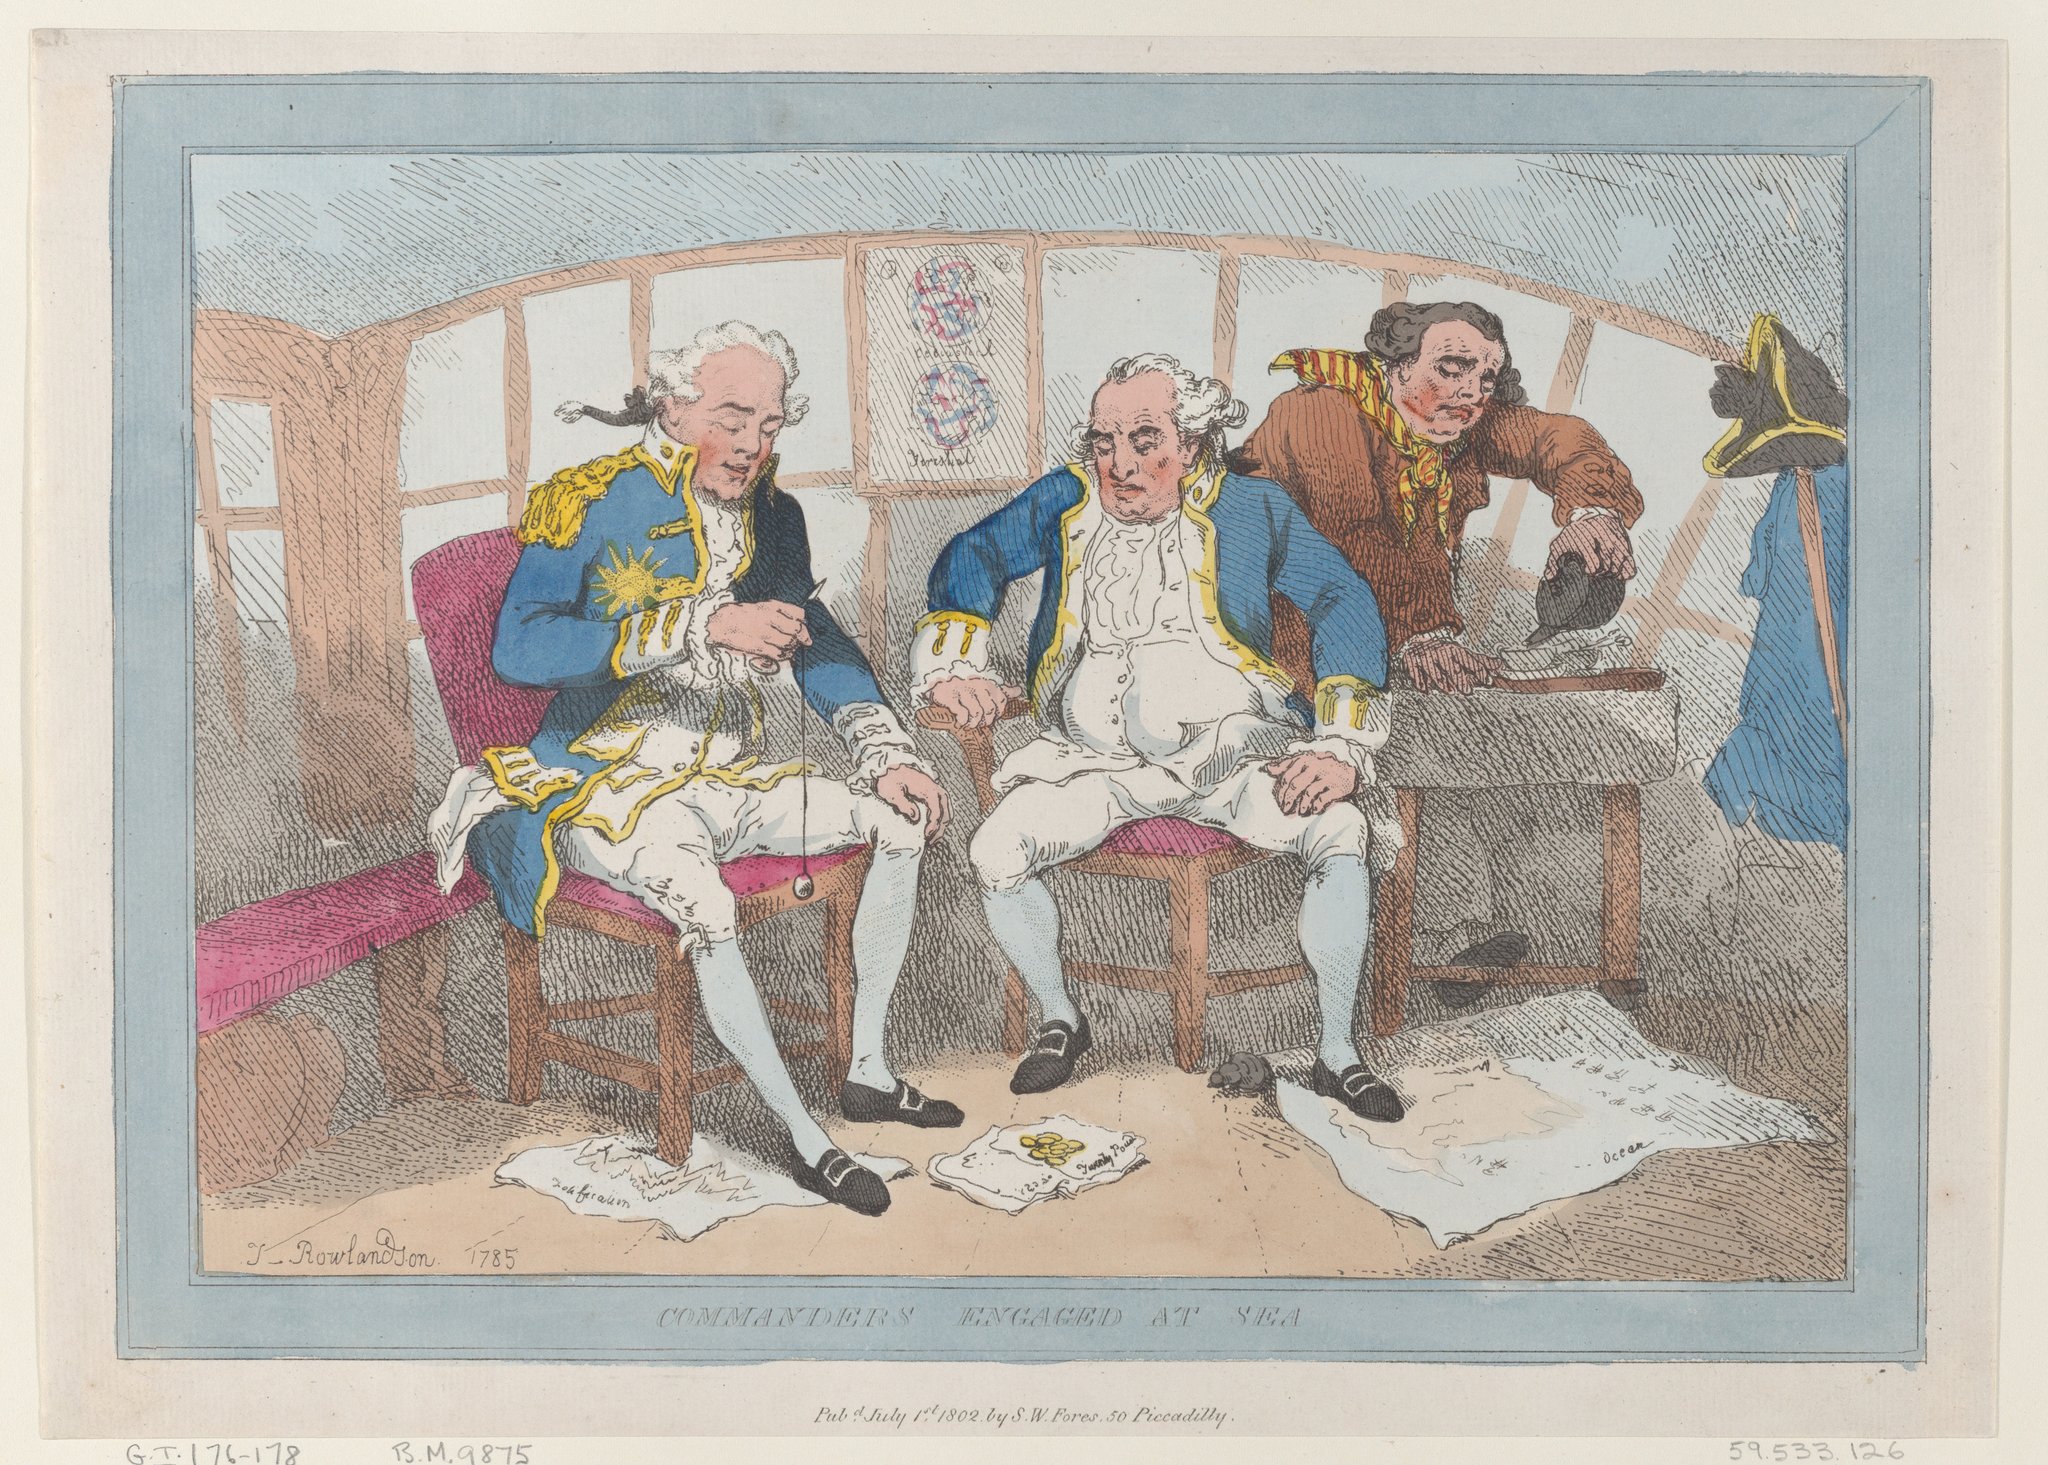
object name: print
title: Commanders Engaged at Sea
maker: thomas rowlandson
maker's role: artist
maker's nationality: british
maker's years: 1757-1827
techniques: etching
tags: satire,men,gambling